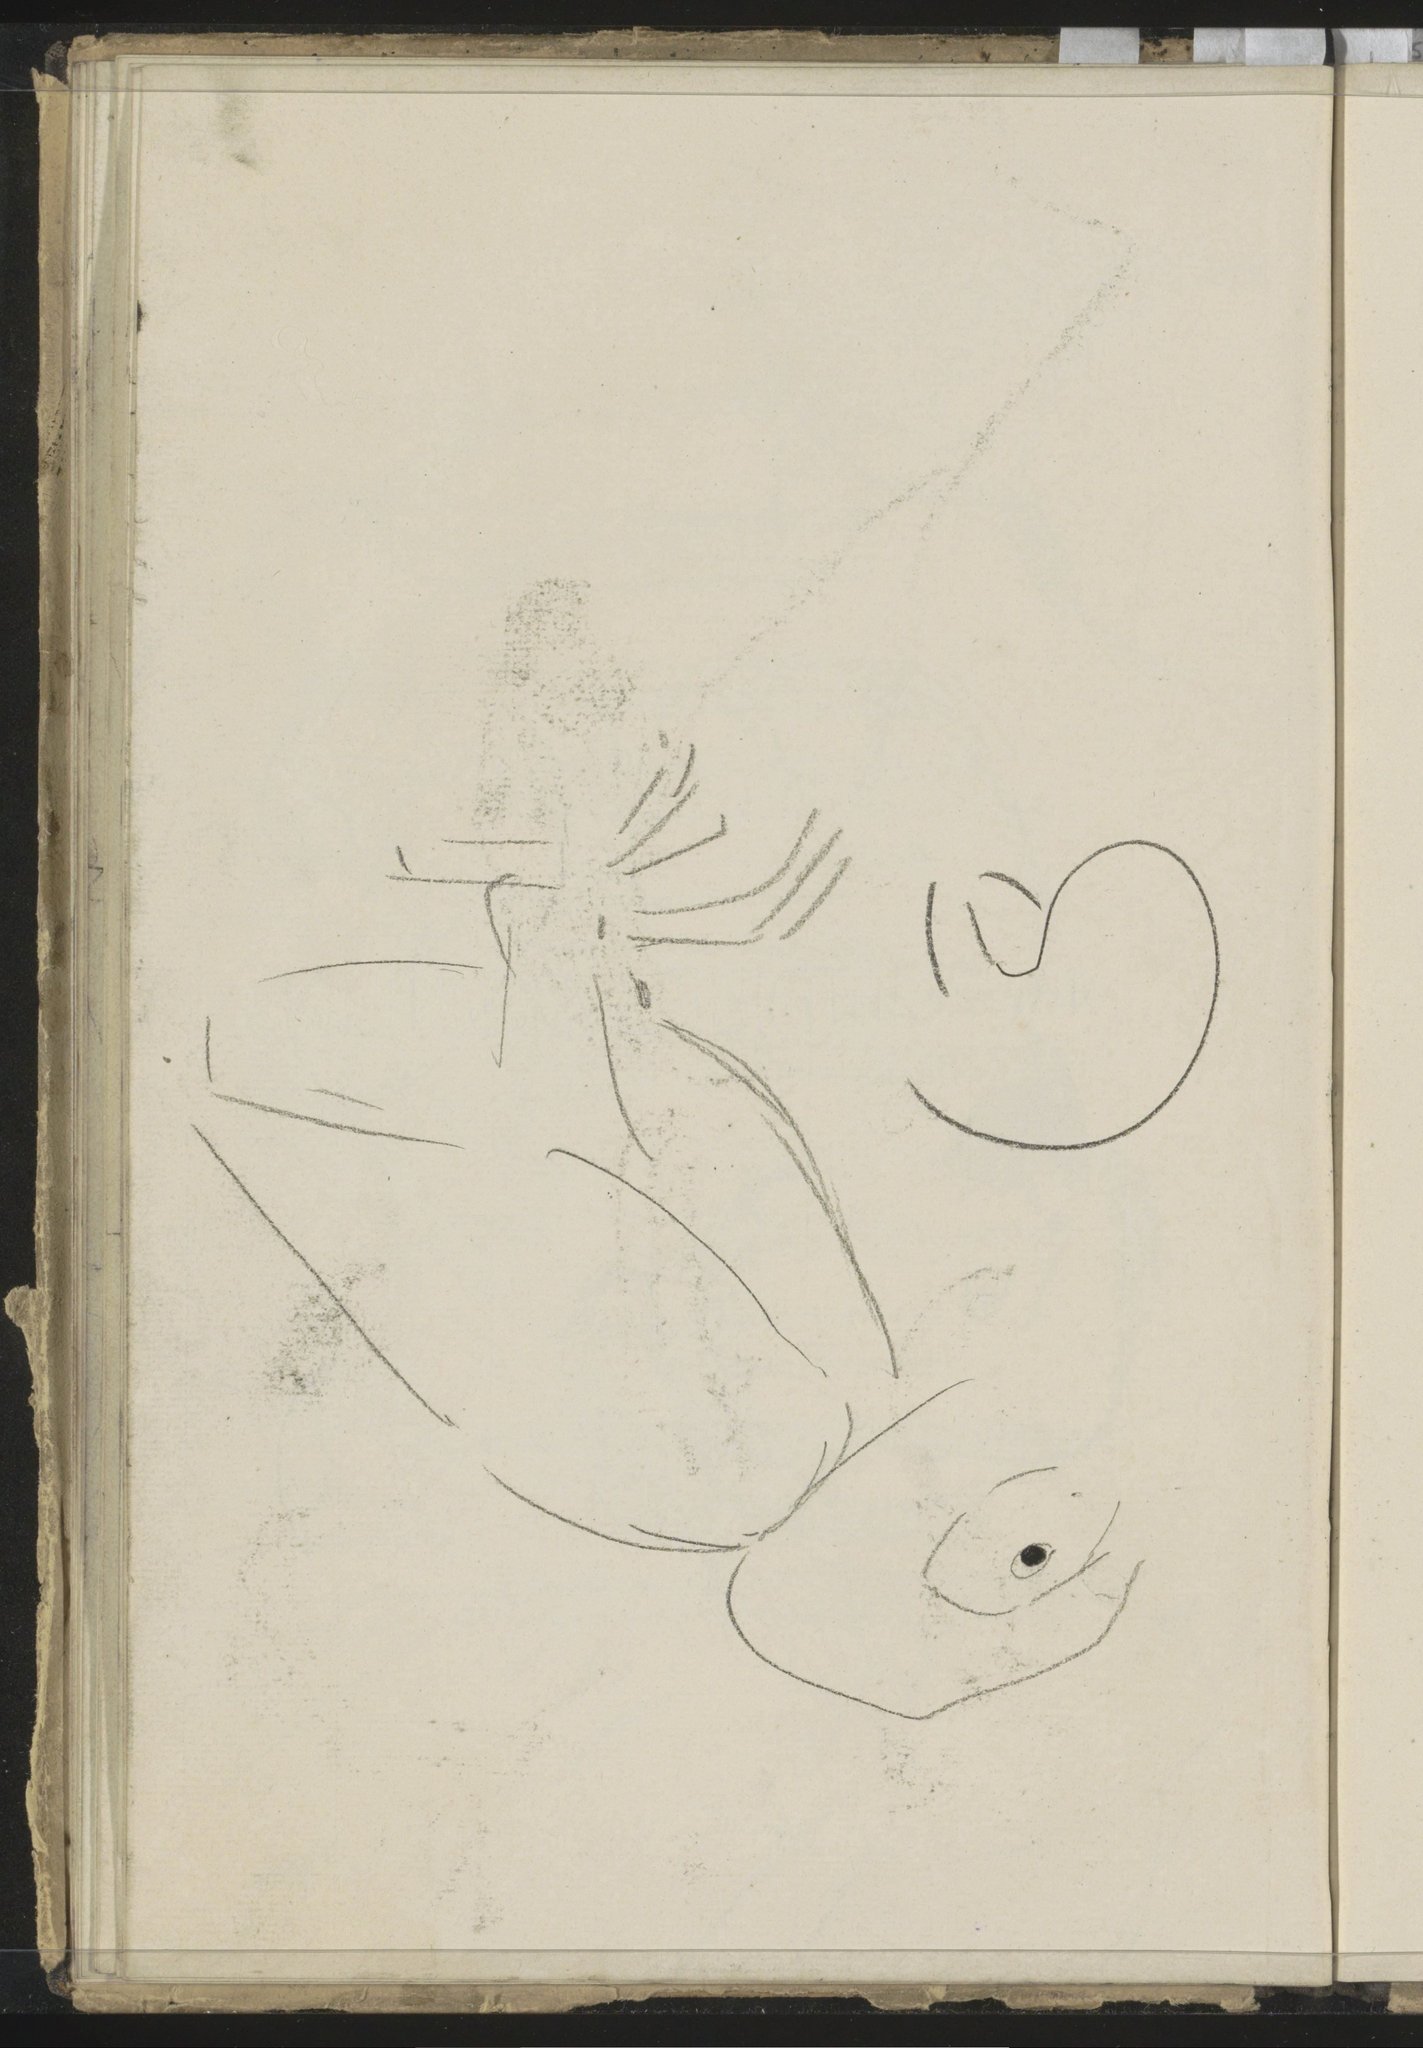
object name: sketchbook leaf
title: Papegaai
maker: carel adolph lion cachet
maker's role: draughtsman, print maker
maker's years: 1864-1945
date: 1890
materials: chalk, paper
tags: ornamental birds: parrot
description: Blad 22 verso uit een schetsboek met 38 bladen.